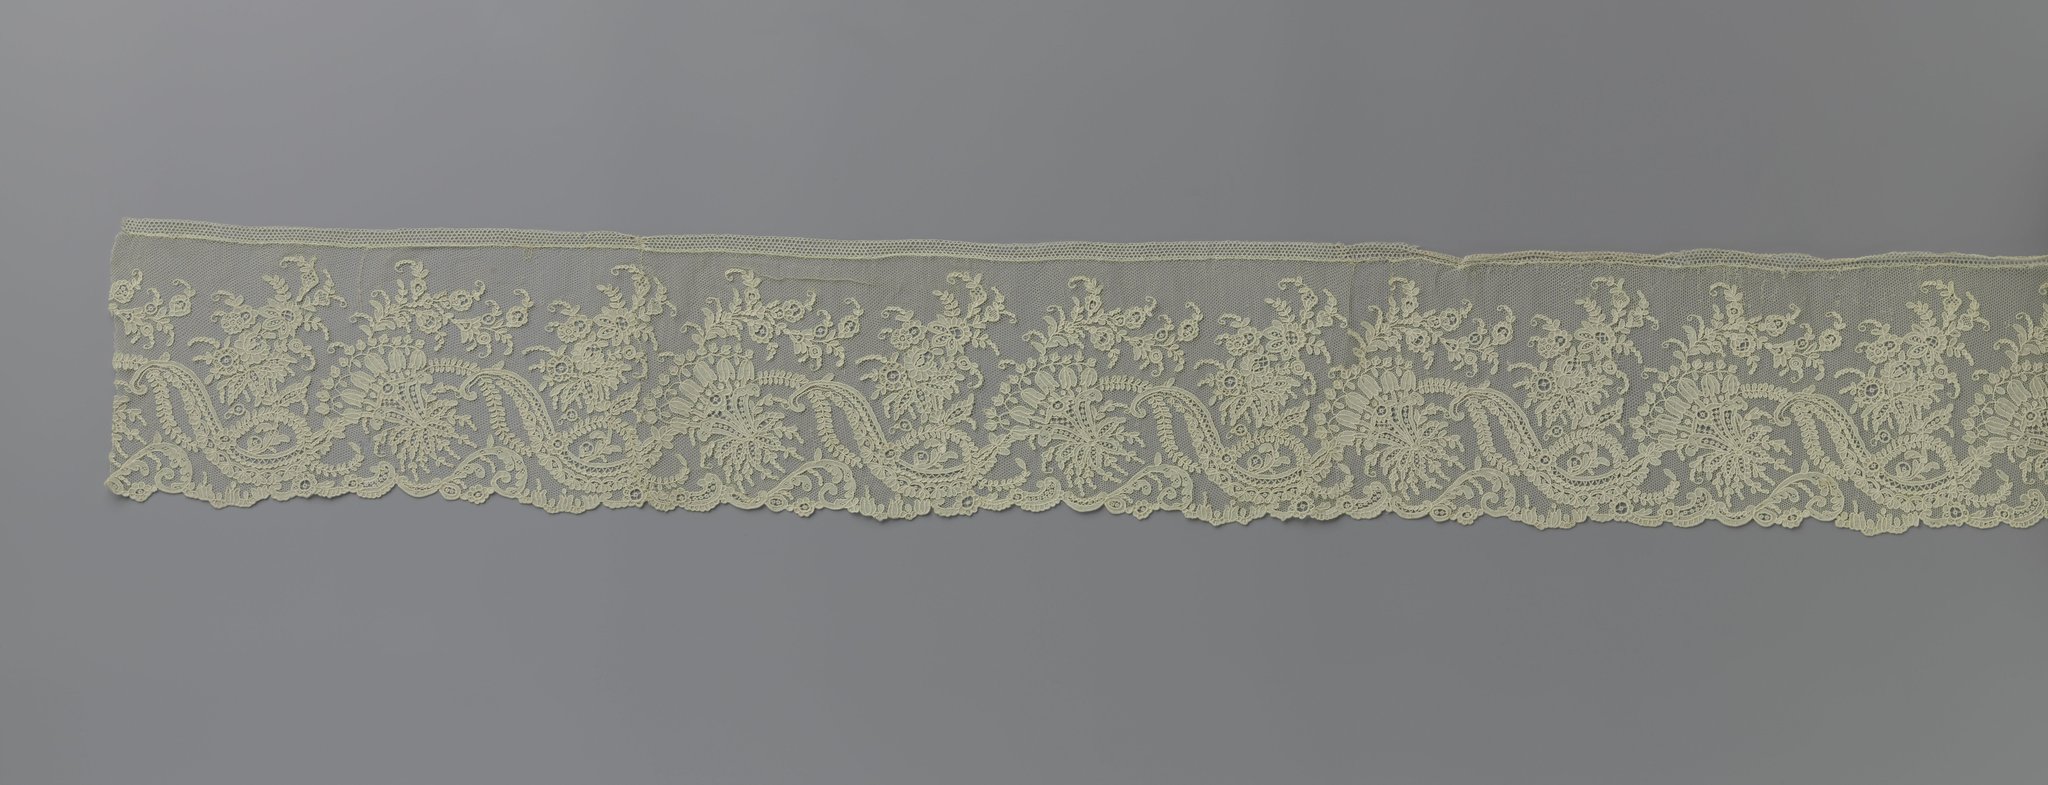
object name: strip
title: Strook naaldkant met boeket en dubbele slingers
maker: Anonymous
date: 1850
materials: linen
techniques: lace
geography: alençon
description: Strook naturelkleurige naaldkant: Alençon-kant. Repetitief motief van een boeket, veelsoortige bloemtakken en dubbele slingers op een fijne zeshoekige maasgrond. Het schuin gerichte boeket met staande en hangende bloemtakken wordt bekroond door een tak met zes hangende klokbloemen. Aan de slingers vele blaadjes, moesjes en raderpicots. Het volwerk versierd met uitsparingen en verschillende siergronden. Aan de onderkant een schulpenrand die ontstaat uit een repetitief motief van voluutranken, rozetvormige bloemen en kelkbloemen. De bovenzijde is afgezet met een rand kloskant.